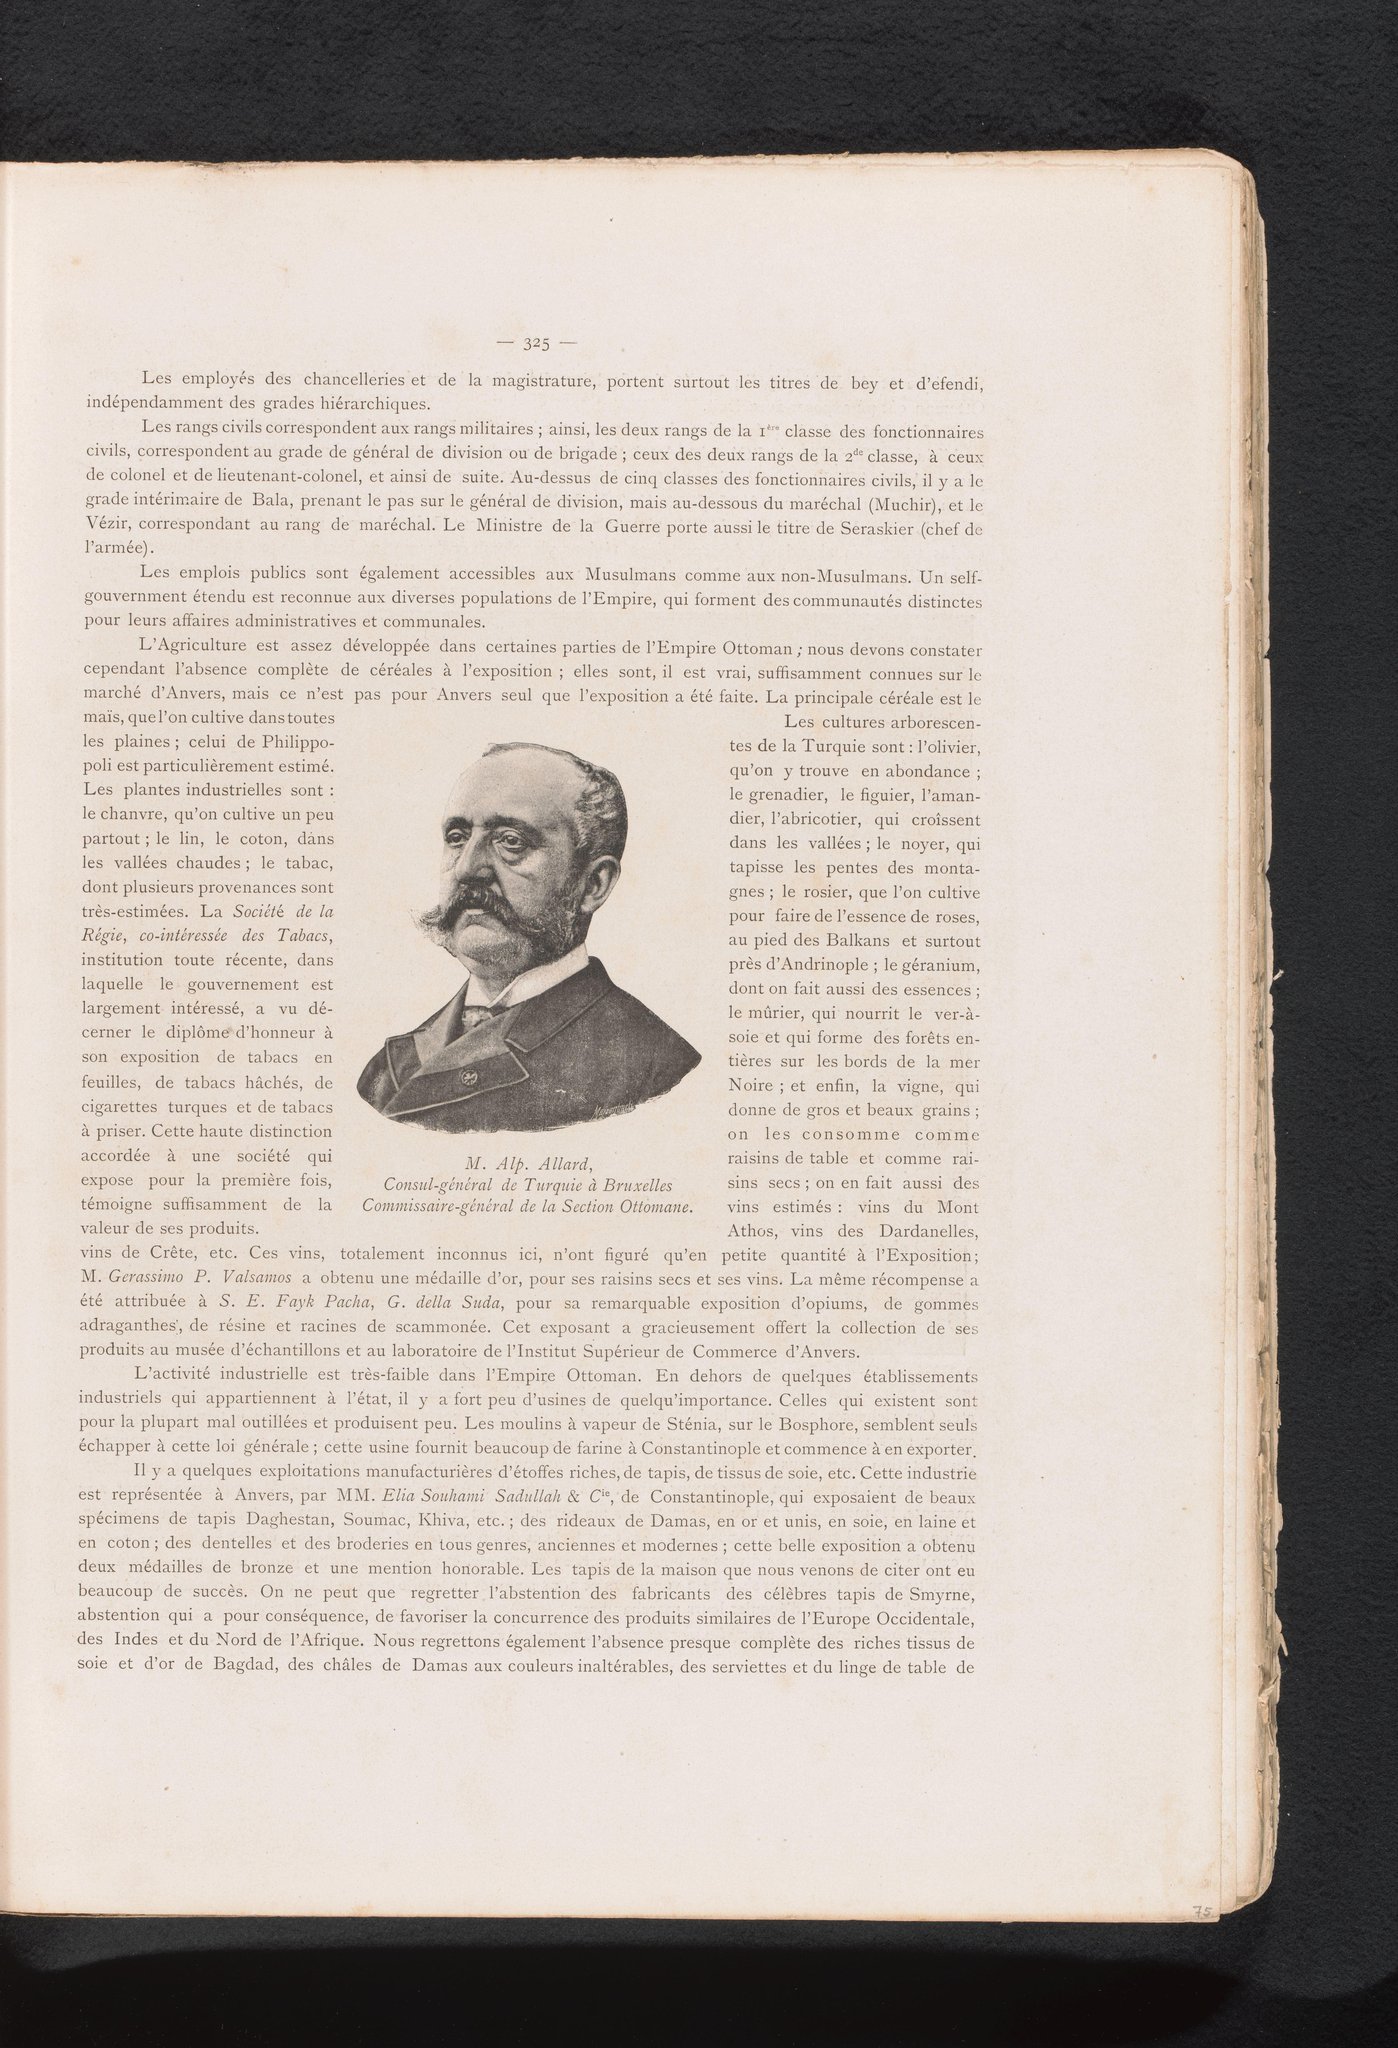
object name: photomechanical print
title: M. Alp. Allard, Consul-général de Turquie à Bruxelles. Commissaire-général de la Section Ottomane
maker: Anonymous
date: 1880-1885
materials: paper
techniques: autotype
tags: historical persons